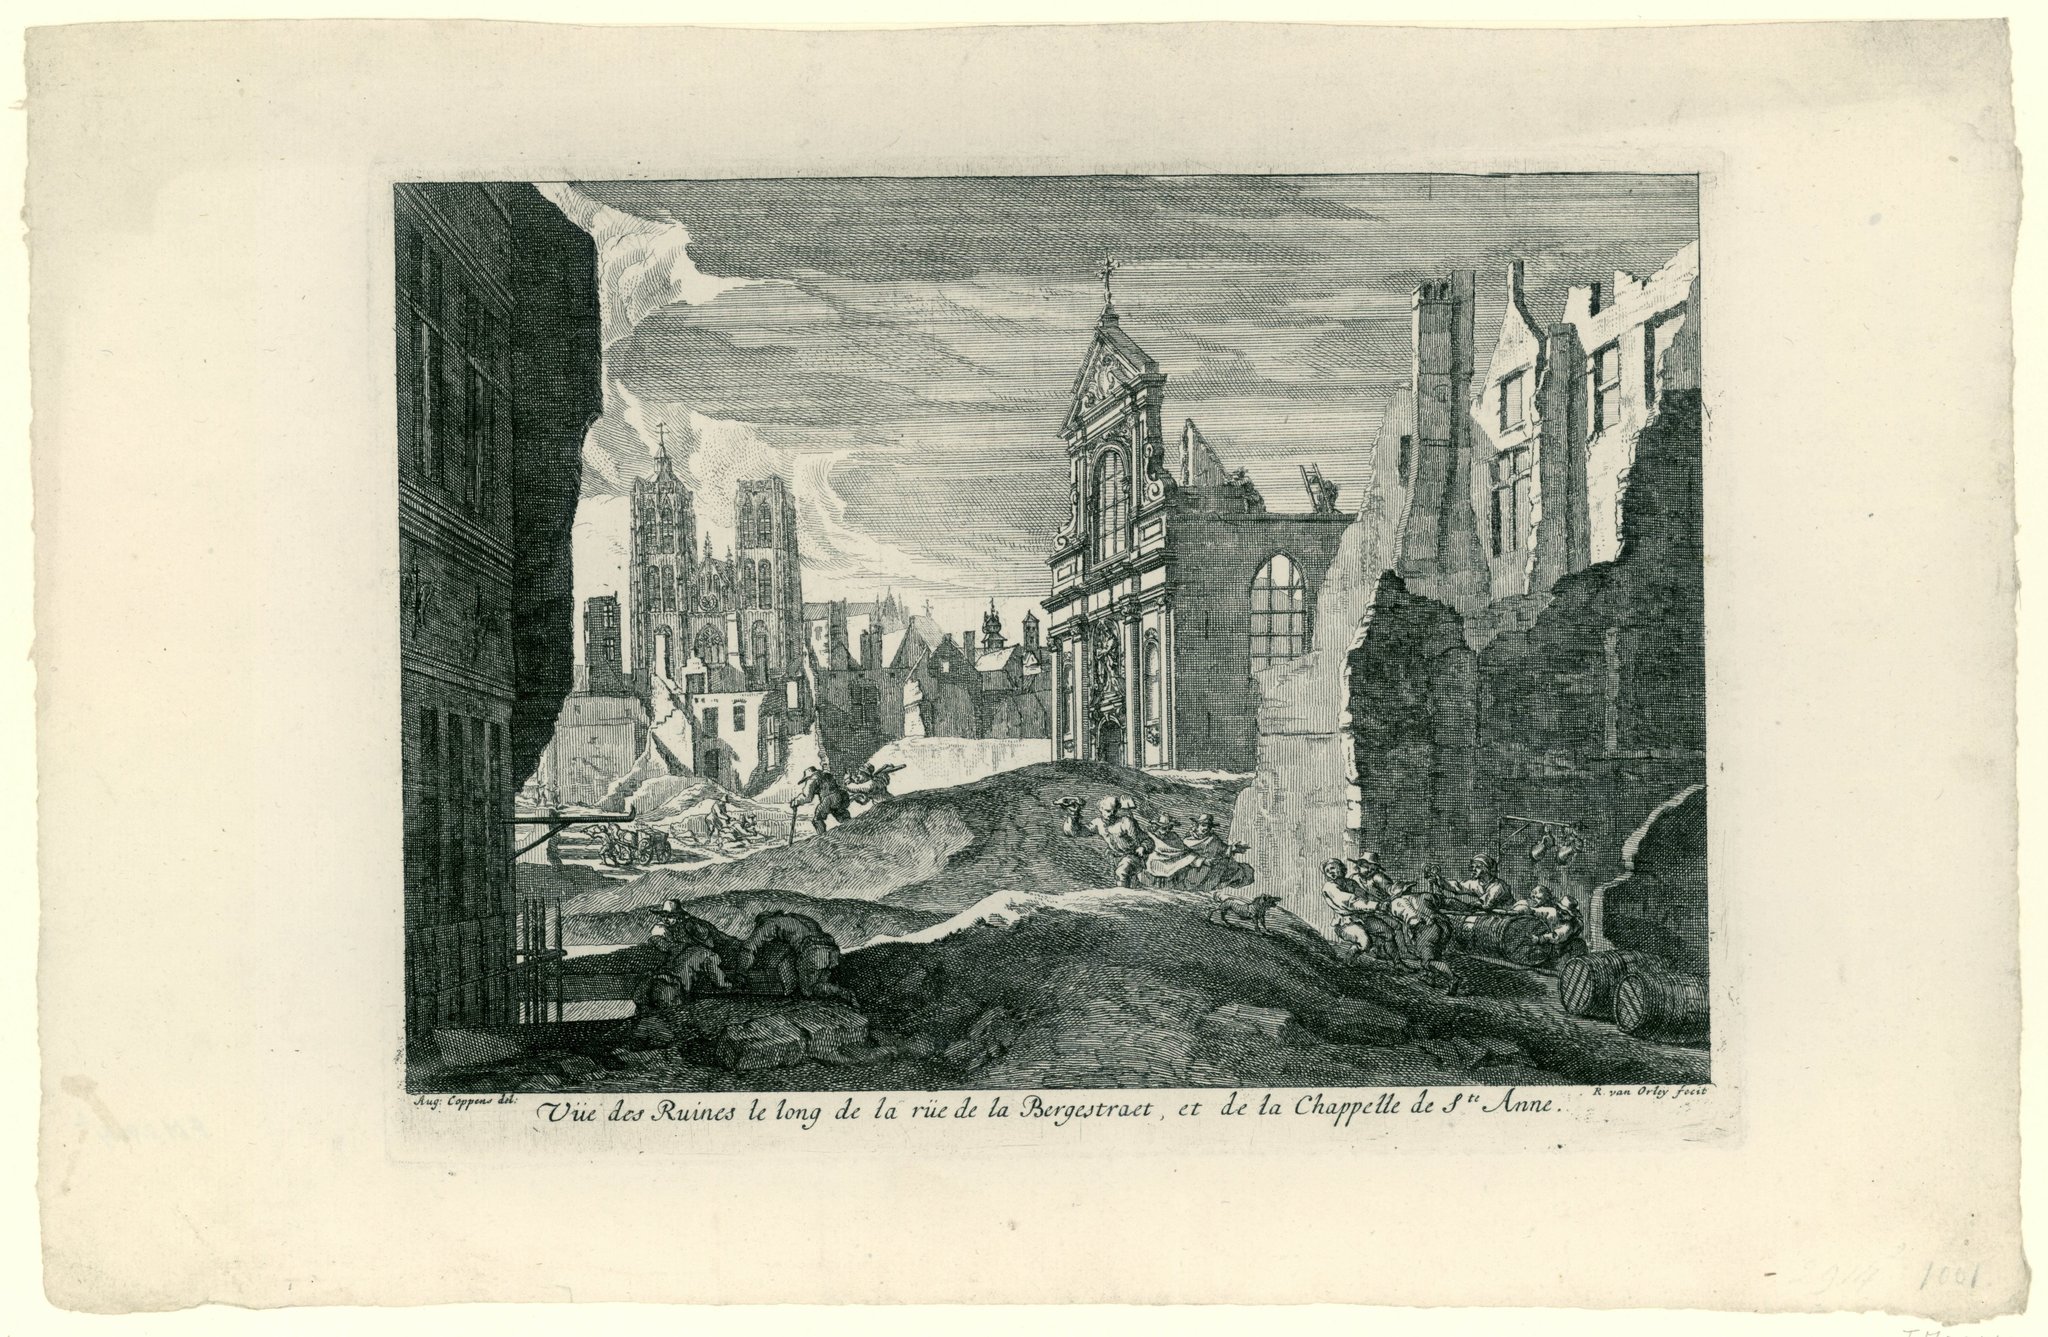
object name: print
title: Ruïnes in de Bergstraat te Brussel, 1695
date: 1695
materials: paper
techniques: etching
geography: southern netherlands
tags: devastated, ruined place or city (~ warfare), brussels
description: Voorstelling van de ruïnes in de Bergstraat te Brussel na het bombardement door de Fransen, 13-15 augustus 1695. Tweede prent in de reeks van twaalf.